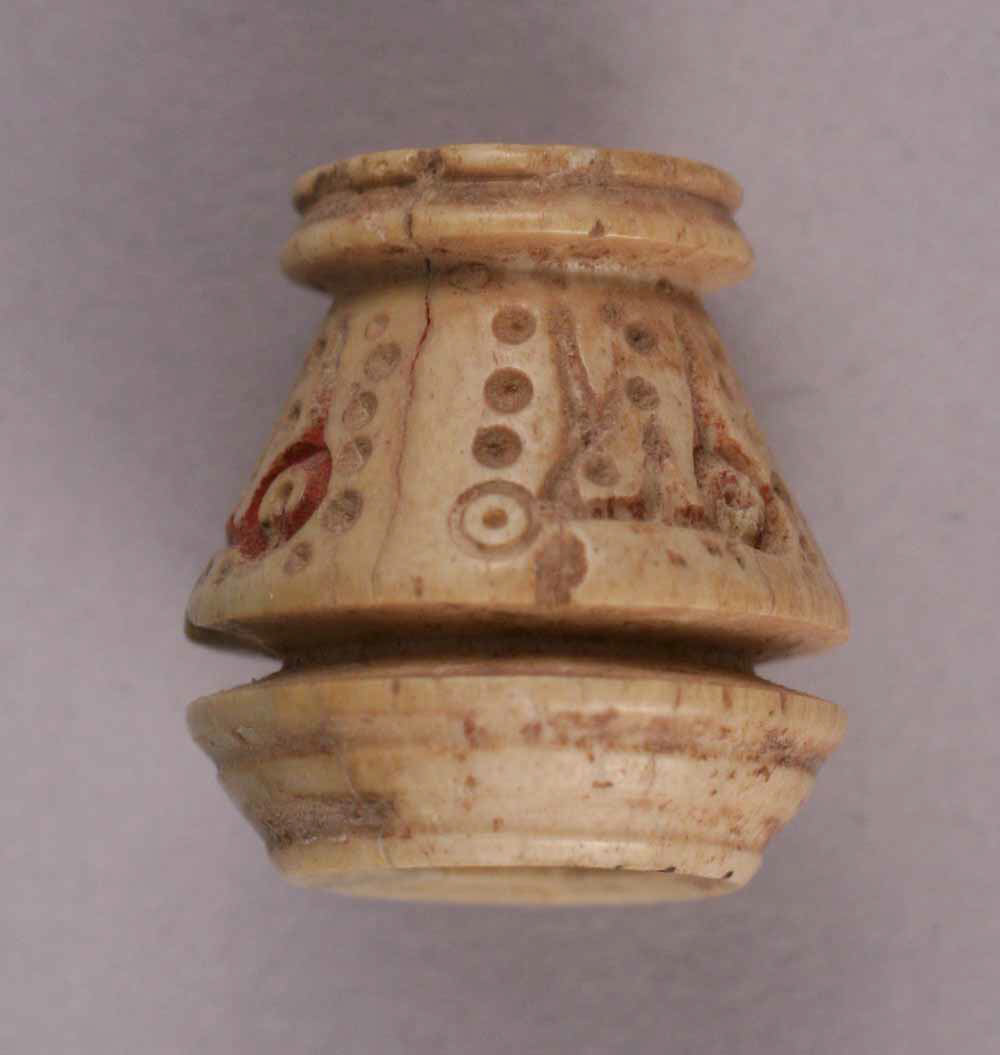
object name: bead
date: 801-1000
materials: bone, paint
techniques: incising, inlay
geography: iran